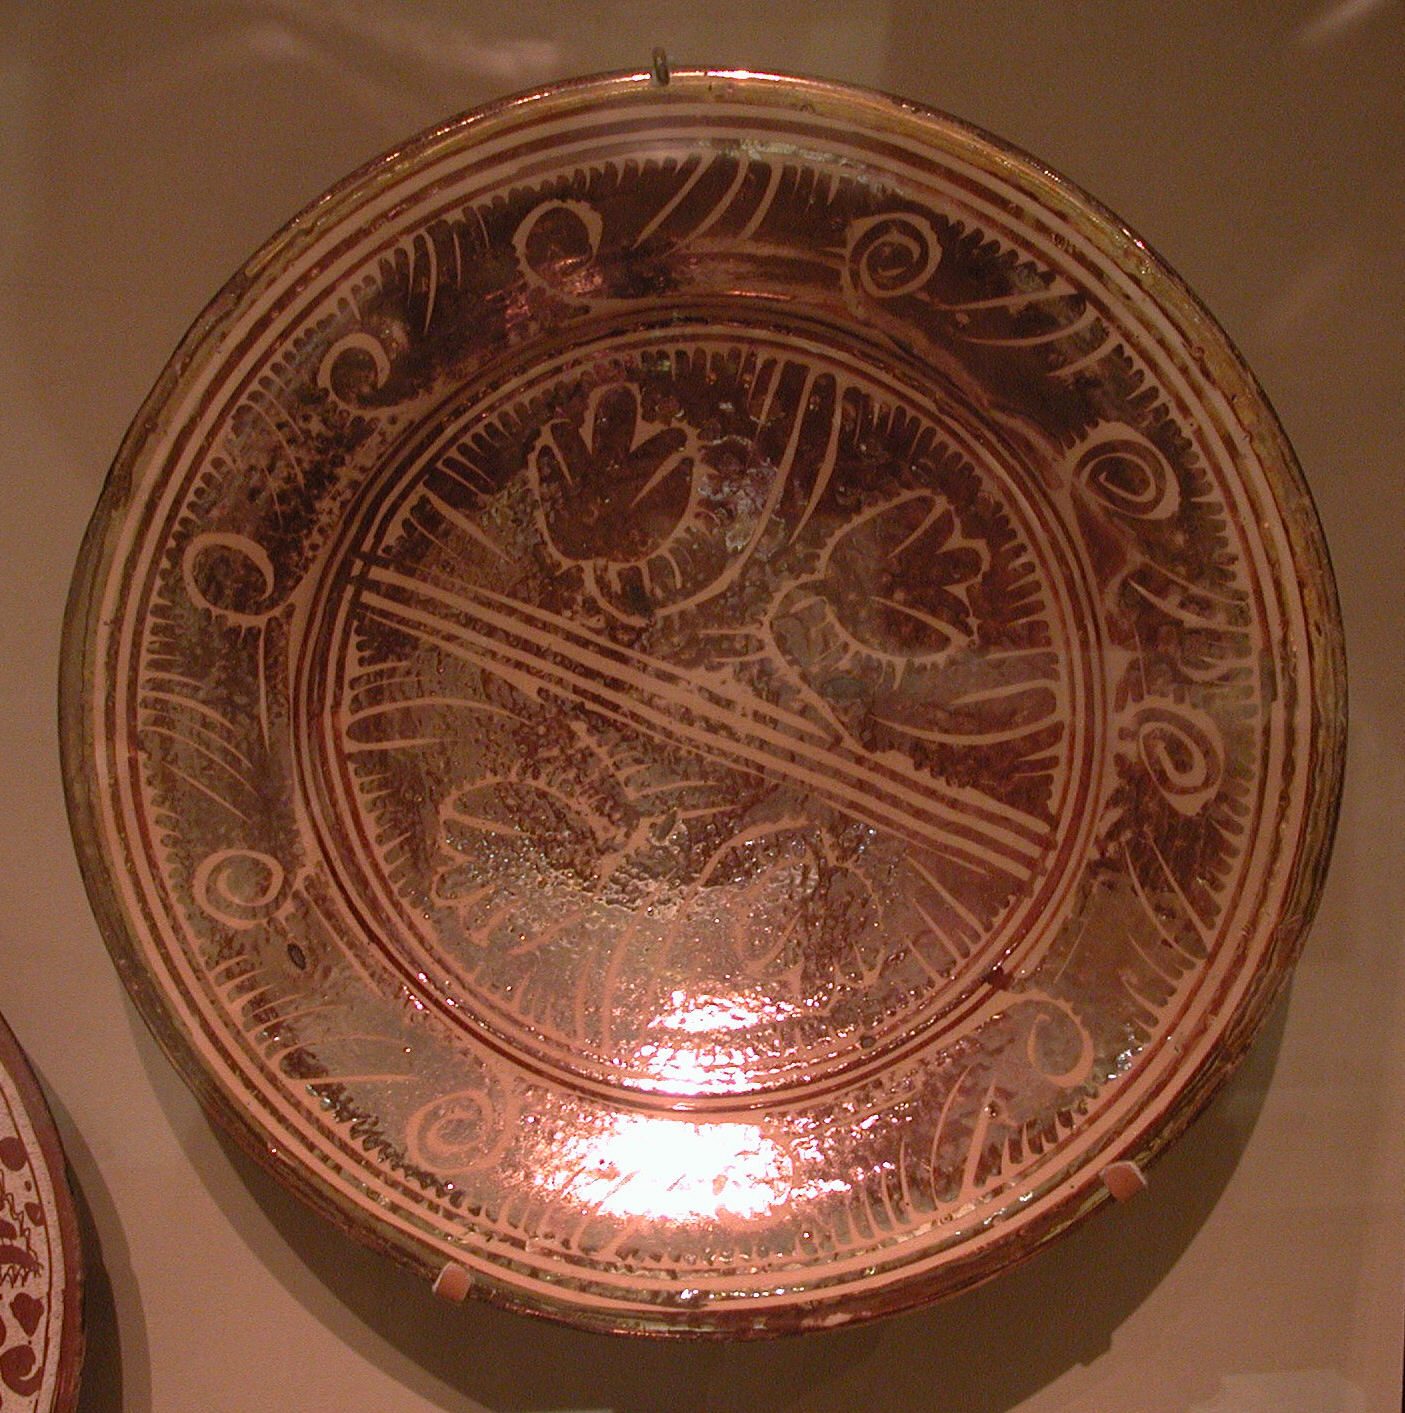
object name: dish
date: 1601-1800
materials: earthenware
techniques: luster painting, glazing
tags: flowers